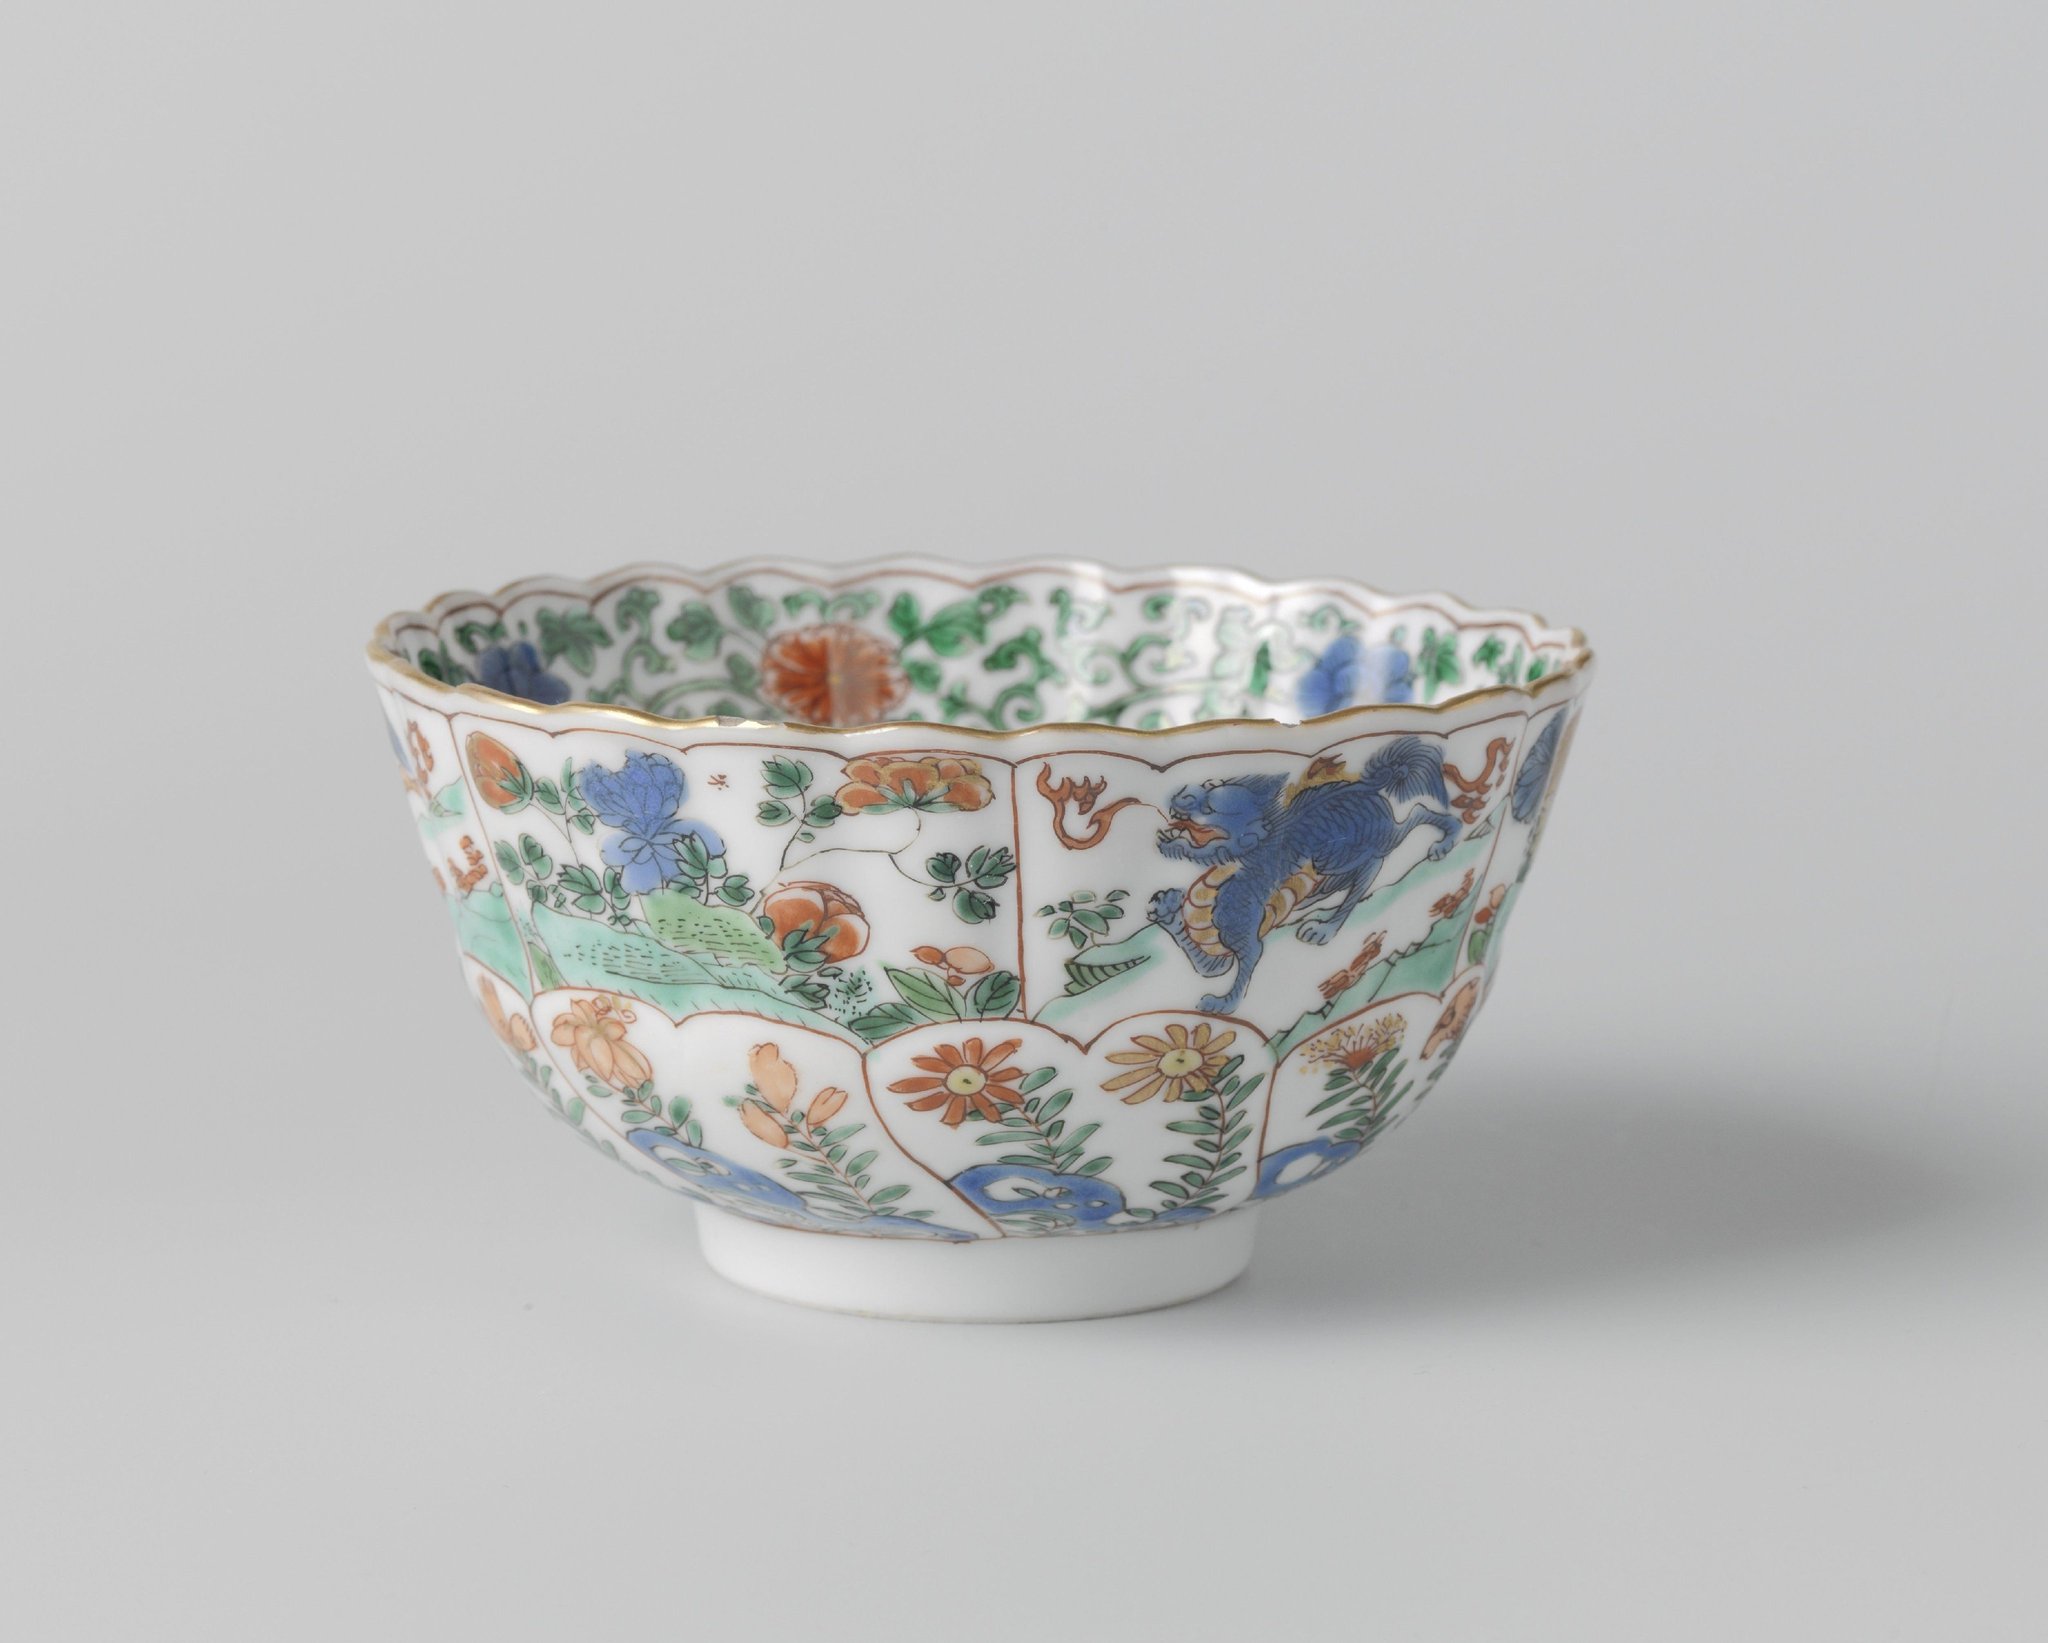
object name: bowl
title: bowl with a pheasant, flowering plants and mythological animals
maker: Anonymous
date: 1700-1724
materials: glaze, gold, paint, porcelain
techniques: firing, gilding, turning, vitrification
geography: china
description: Kom van porselein met een geribde wand en gelobde rand, beschilderd op het glazuur in blauw, rood, groen, geel, aubergine, zwart en goud. De buitenwand is verdeeld in twee banden. De bovenste band bestaat uit zes vakken met afwisselend bloeiende planten (lotus, pioen, chrysant) en drie mythologische dieren (shishi, qilin). De onderste band bestaat uit getordeerde vakken met bloeiende planten bij een rots. Op de bodem een fazant op een rots bij bloeiende pioenen. De binnenrand met een band met bloemranken. Een chip in de rand. Famille verte.